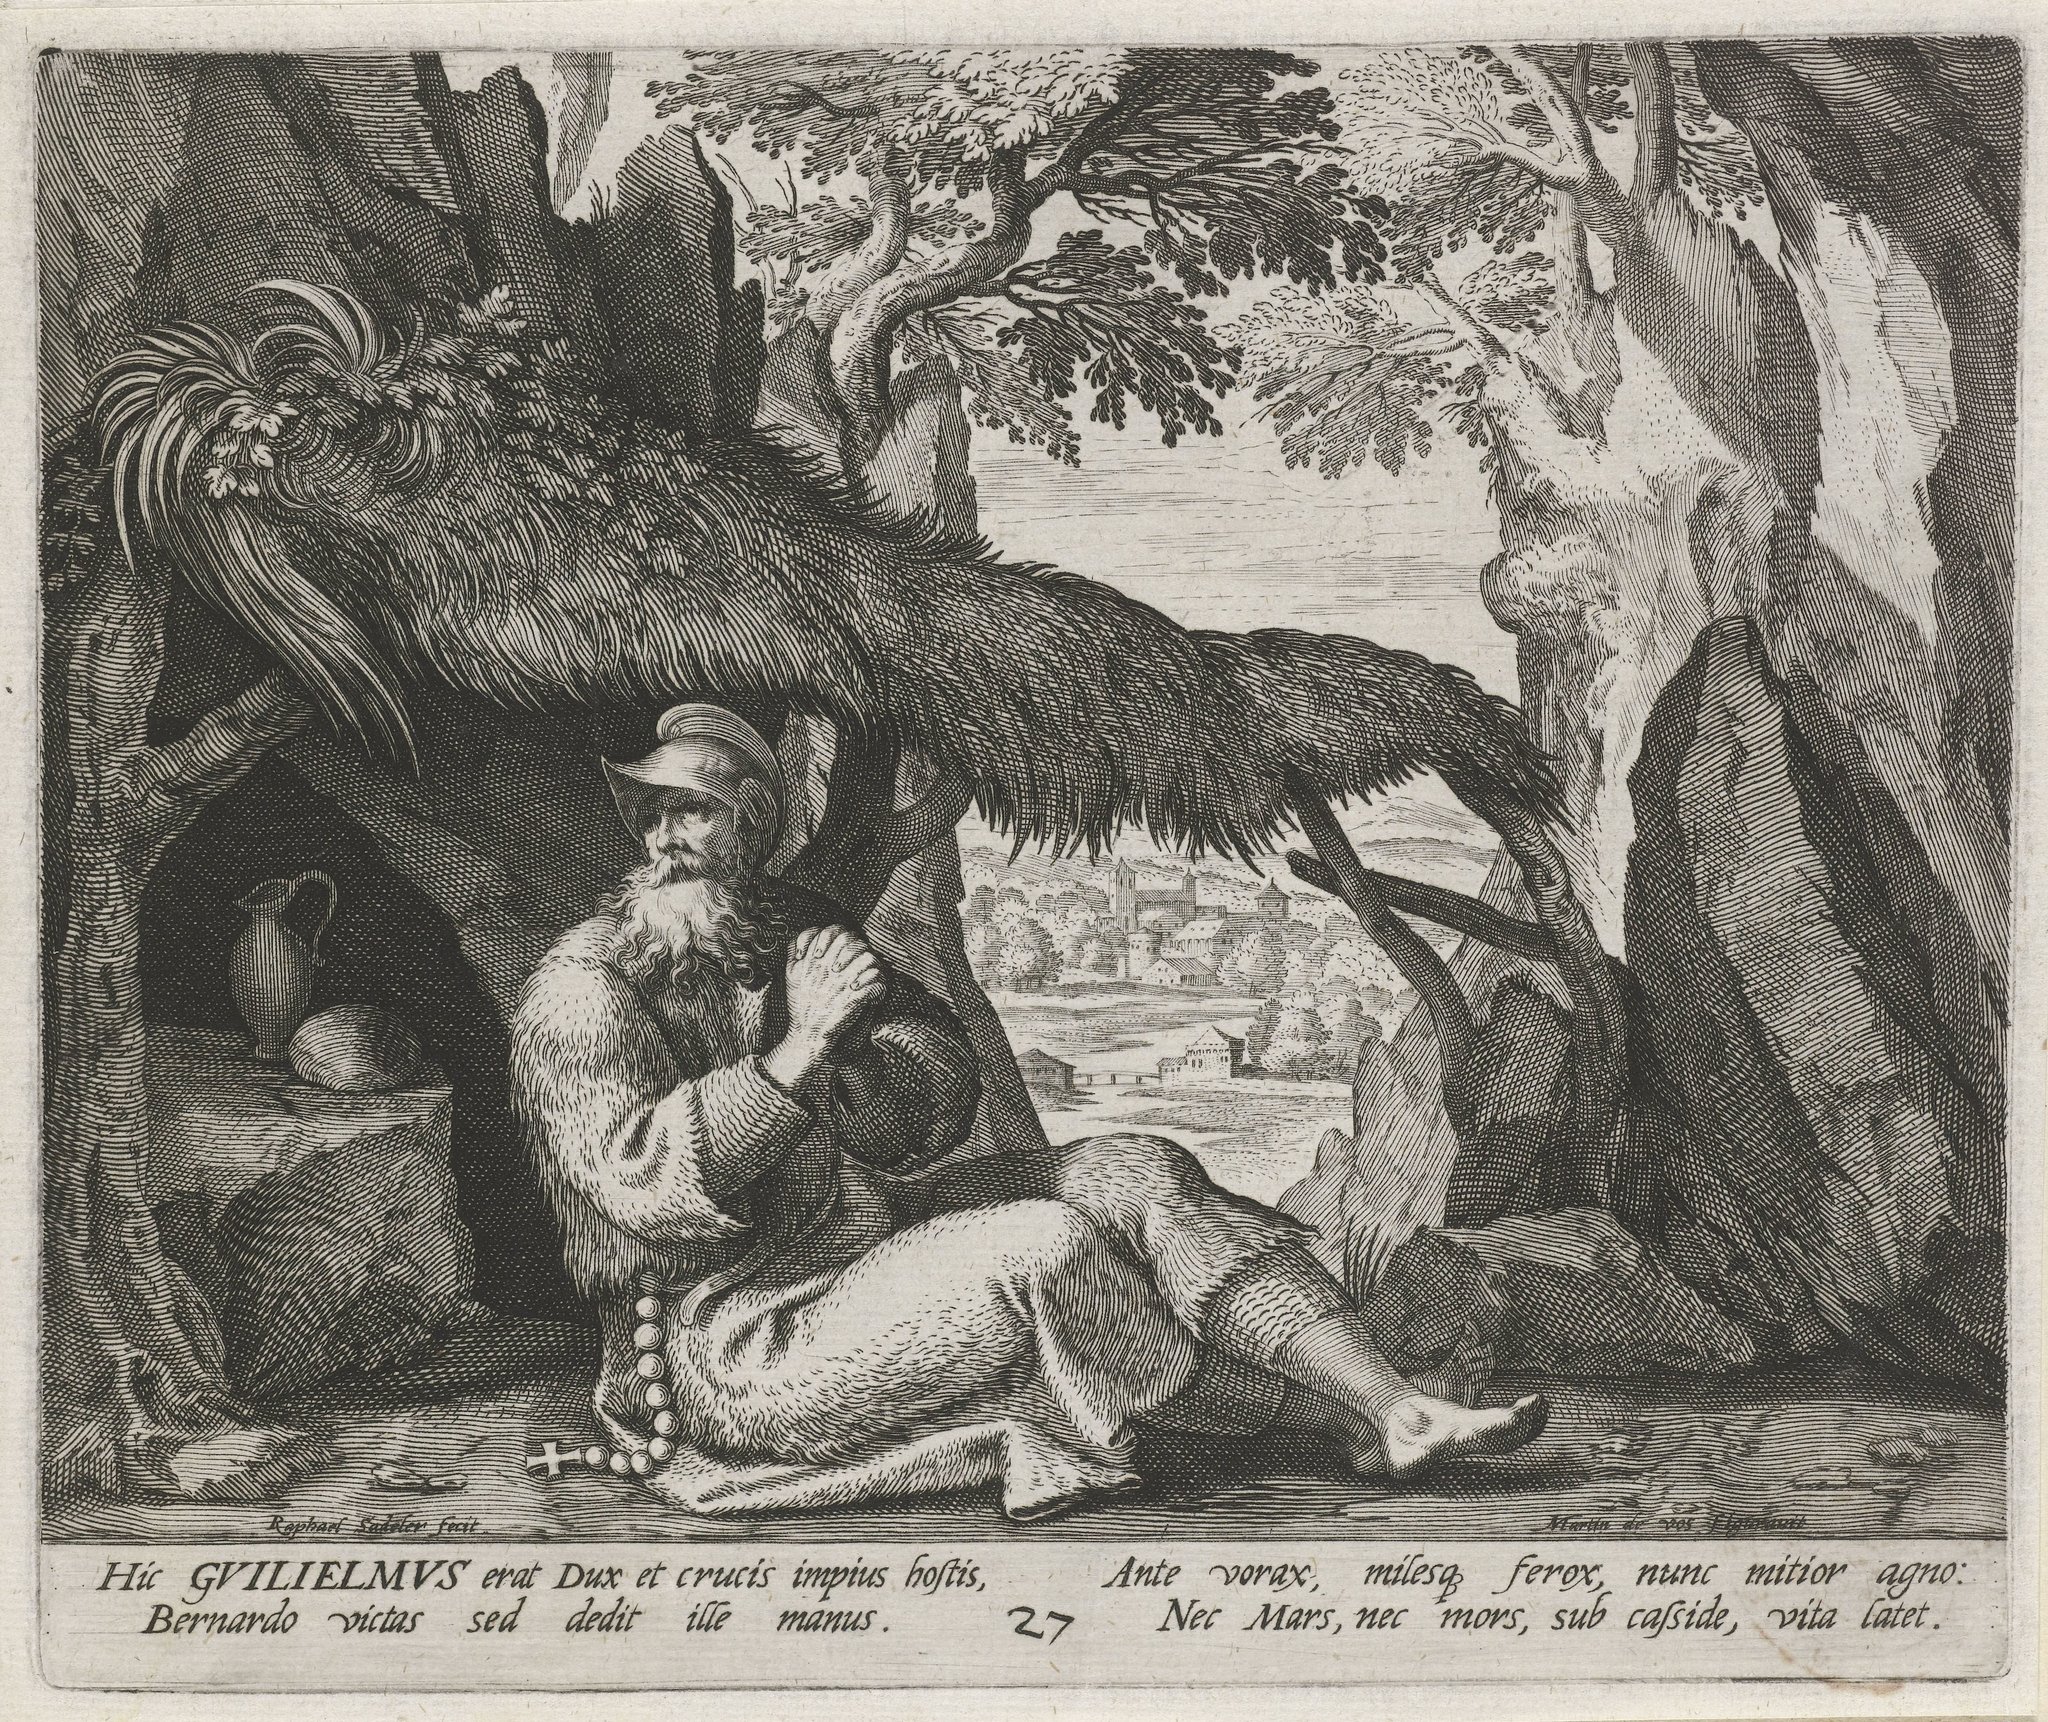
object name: print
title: Heilige Willem van Aquitanië als kluizenaar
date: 1594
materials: paper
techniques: engraving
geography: munich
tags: personal devotion of st. william of aquitaine - male saint meditating, in ecstasy, anchorite, hermit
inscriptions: collector's mark: Lugt 240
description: De H. Willem, hertog van Aquitanië, een Franse hertog en kluizenaar uit de achtste eeuw na Christus. Hij zit voor zijn kluis te bidden. Op zijn hoofd een wapenhelm.